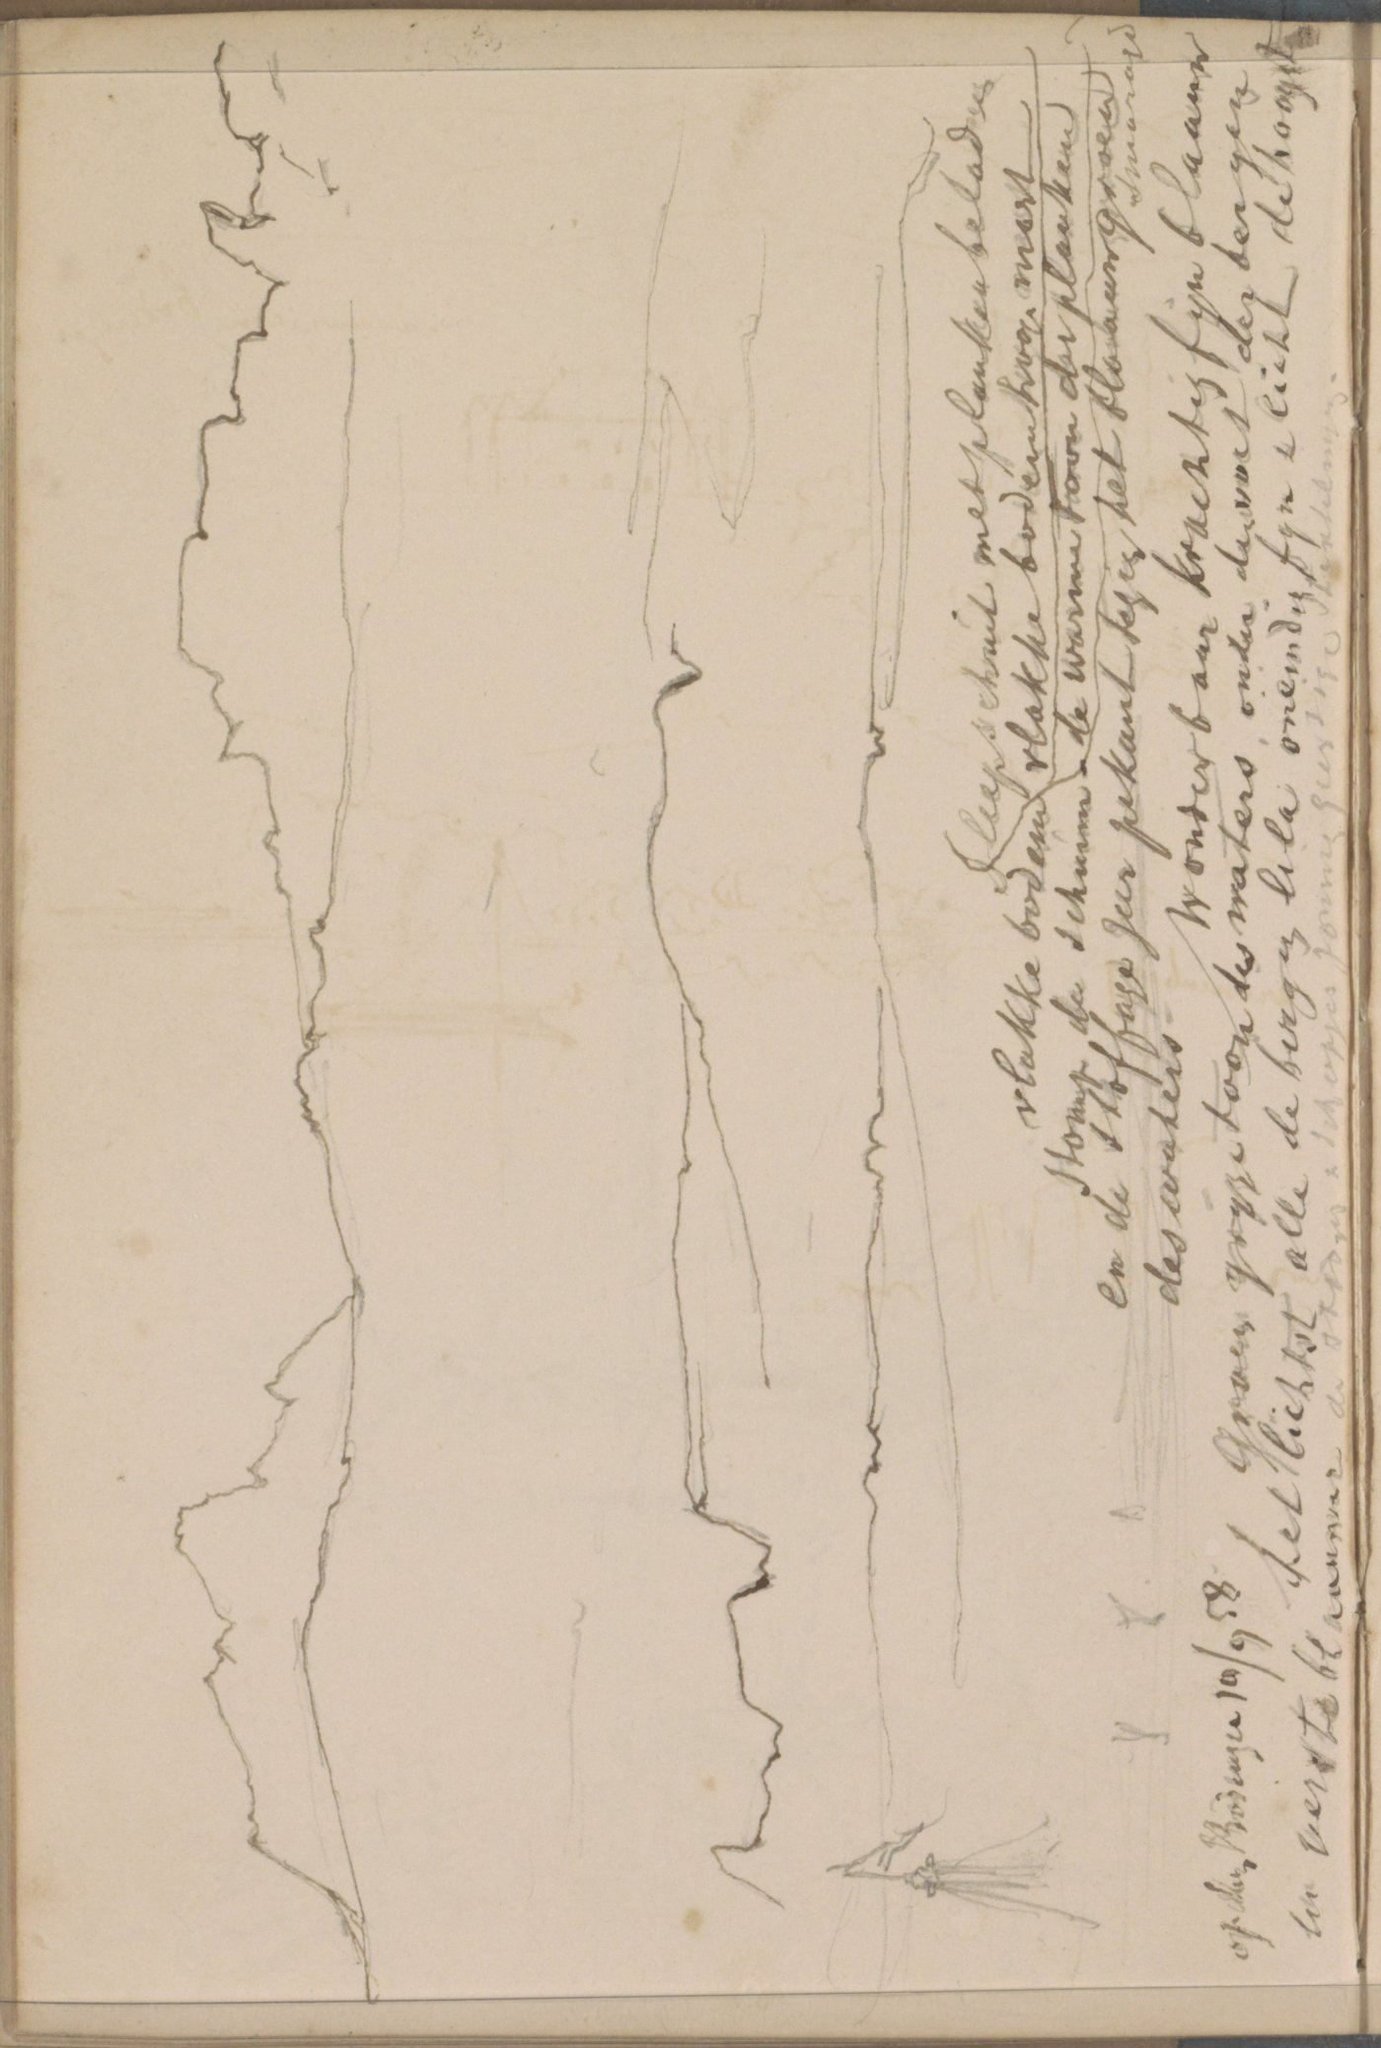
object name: sketchbook leaf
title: Berglandschap gezien vanuit een boot op het Bodenmeer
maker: johannes tavenraat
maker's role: draughtsman, painter, print maker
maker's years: 1809-1881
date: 1809-1858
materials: ink, paper, pencil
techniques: pen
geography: lake constance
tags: lake, mountains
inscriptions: date and inscription: ‘op de Bodenzee 10/9 58’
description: Blad 29 verso uit een schetsboek met 47 bladen.